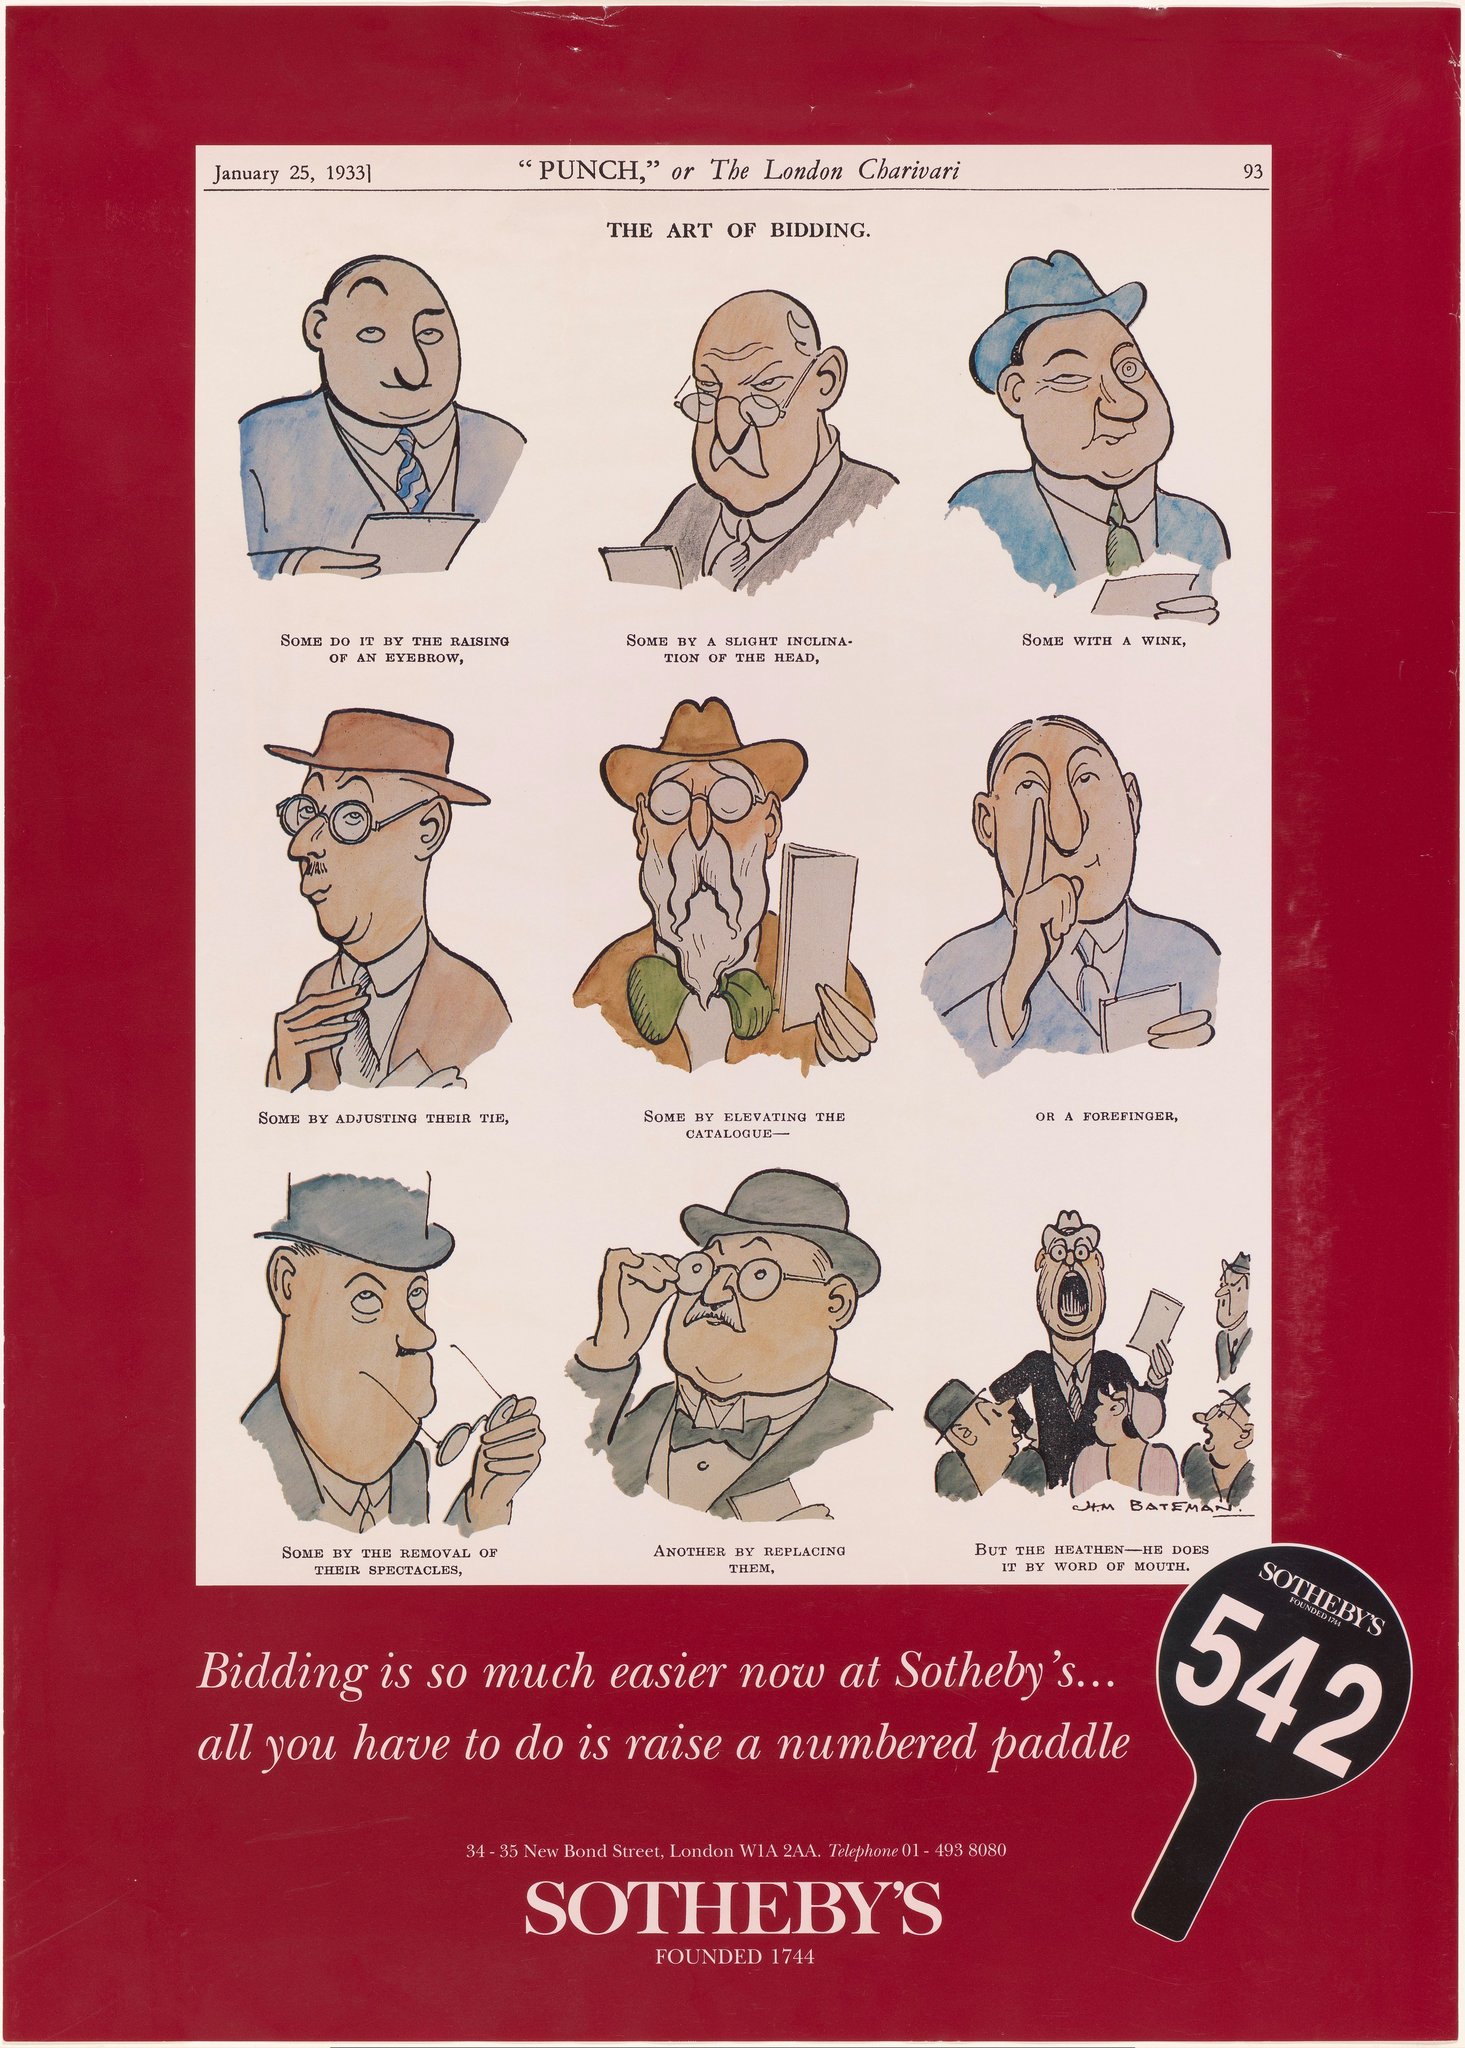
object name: poster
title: Affiche waarin Sotheby's reclame maakt voor het bieden per nummer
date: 1990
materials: paper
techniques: mechanical printing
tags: gesture-language, art sale, auction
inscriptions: collector's mark: Lugt 2228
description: Affiche met een illustratie uit het tijdschrift Punch uit 1933 met daarop negen manieren om tijdens een veiling een bod uit te brengen. Deze zijn door Sotheby's vervangen door een bord met een nummer.